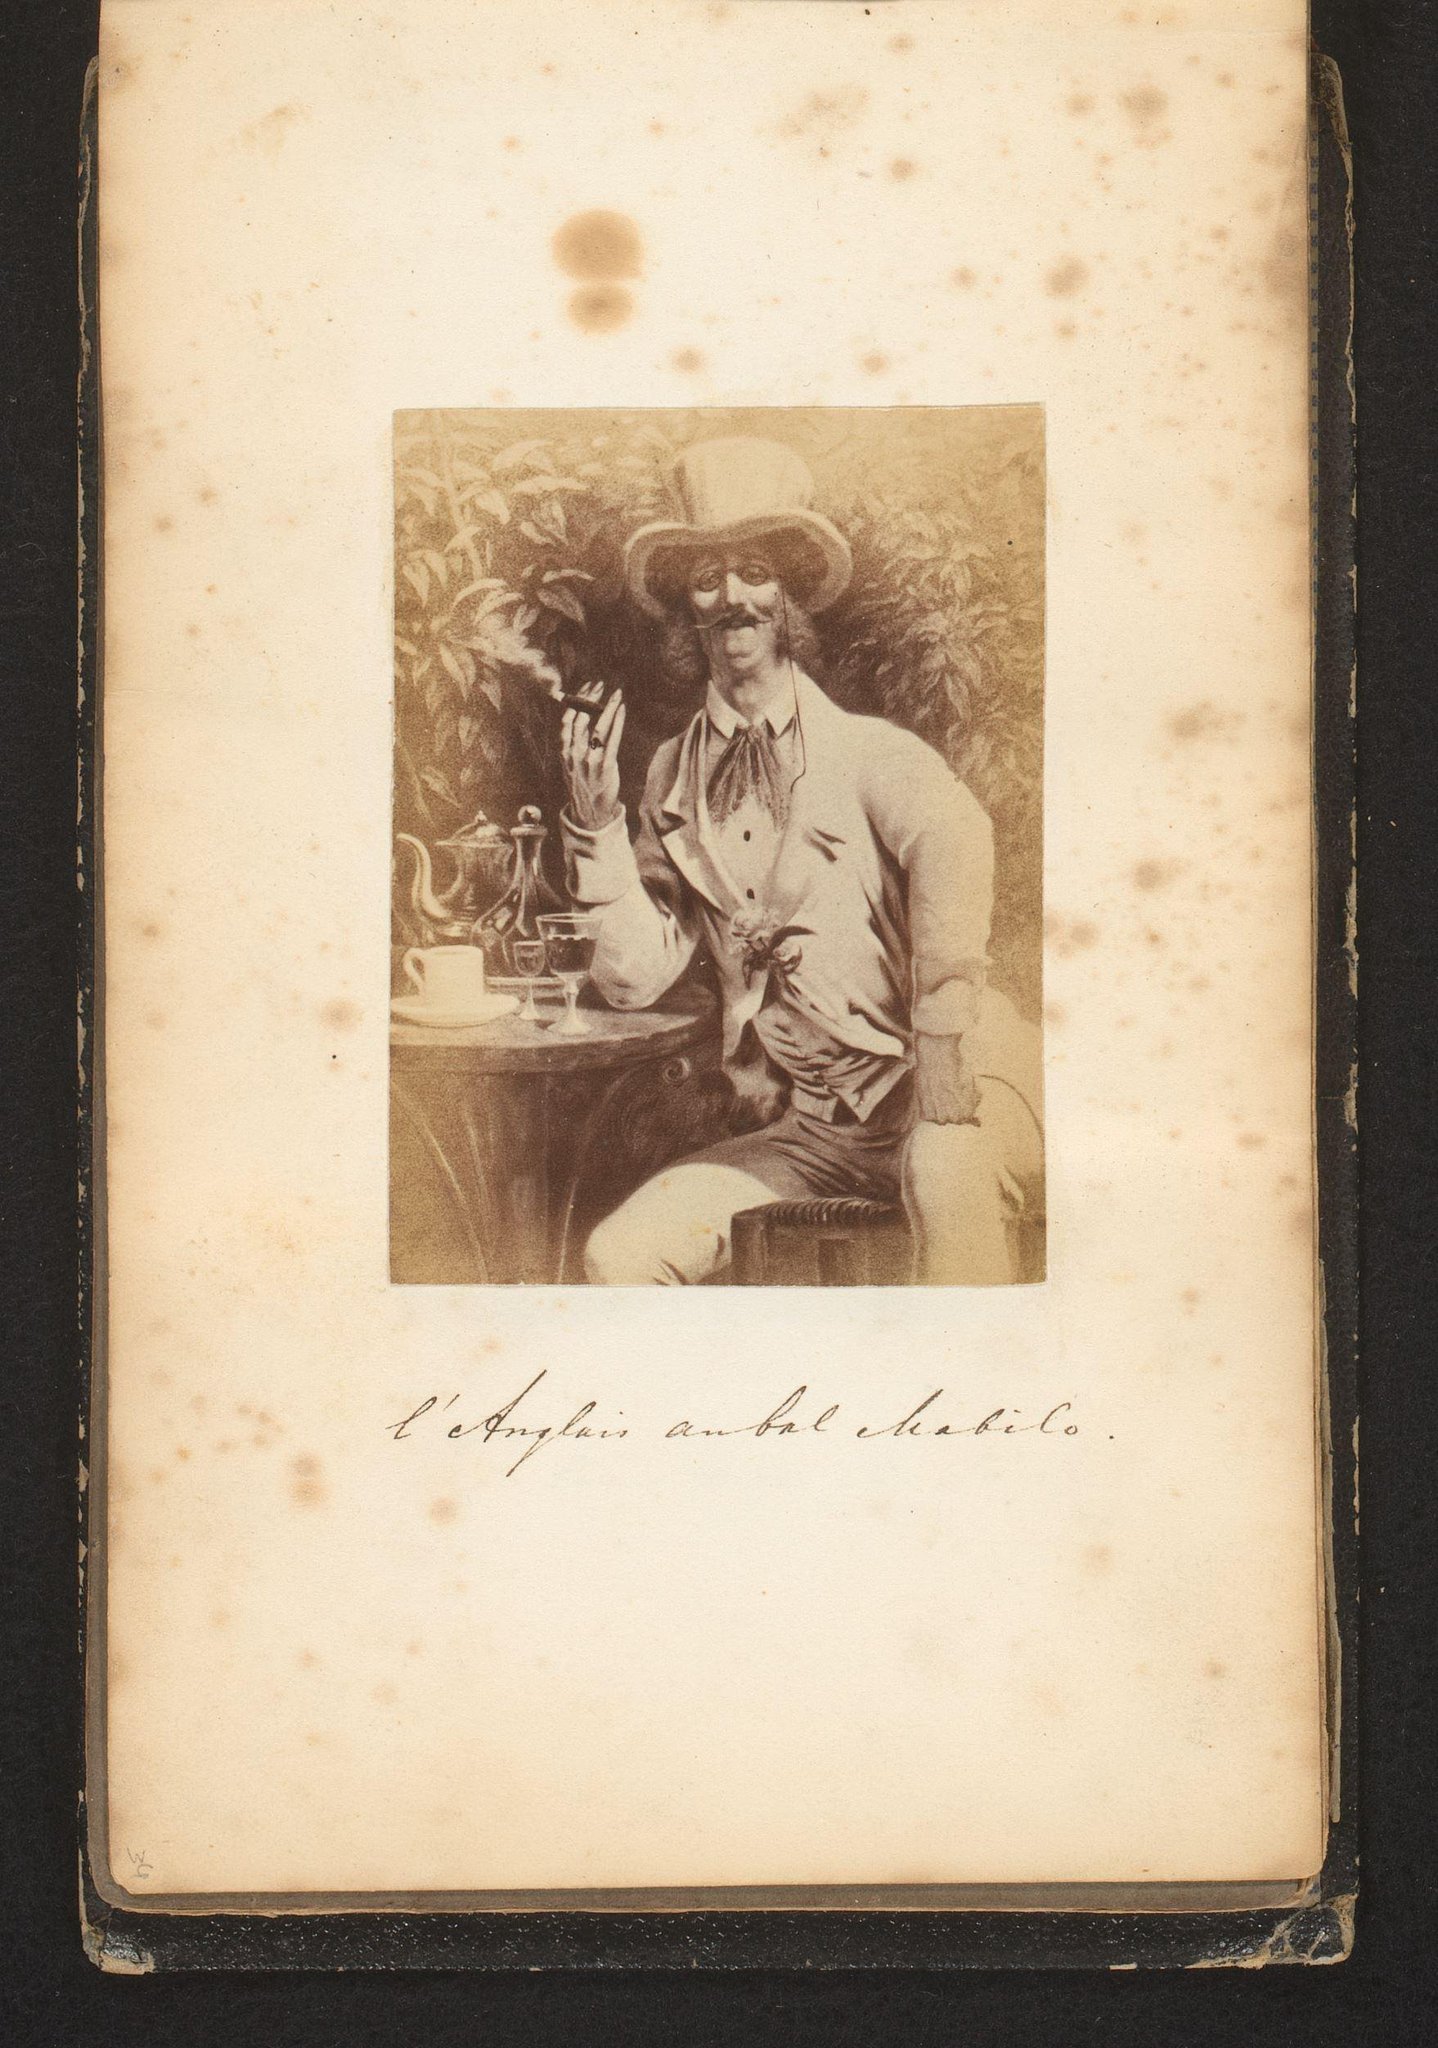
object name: reproduction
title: Fotoreproductie van een geschilderd portret van een man, zittend in een tuin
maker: Anonymous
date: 1860-1900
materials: photographic support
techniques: albumen print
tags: eyeglasses, spectacles, sitting figure, cigar, garden, painting, drawing and the graphic arts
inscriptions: annotation: ‘l'Anglais [...]’